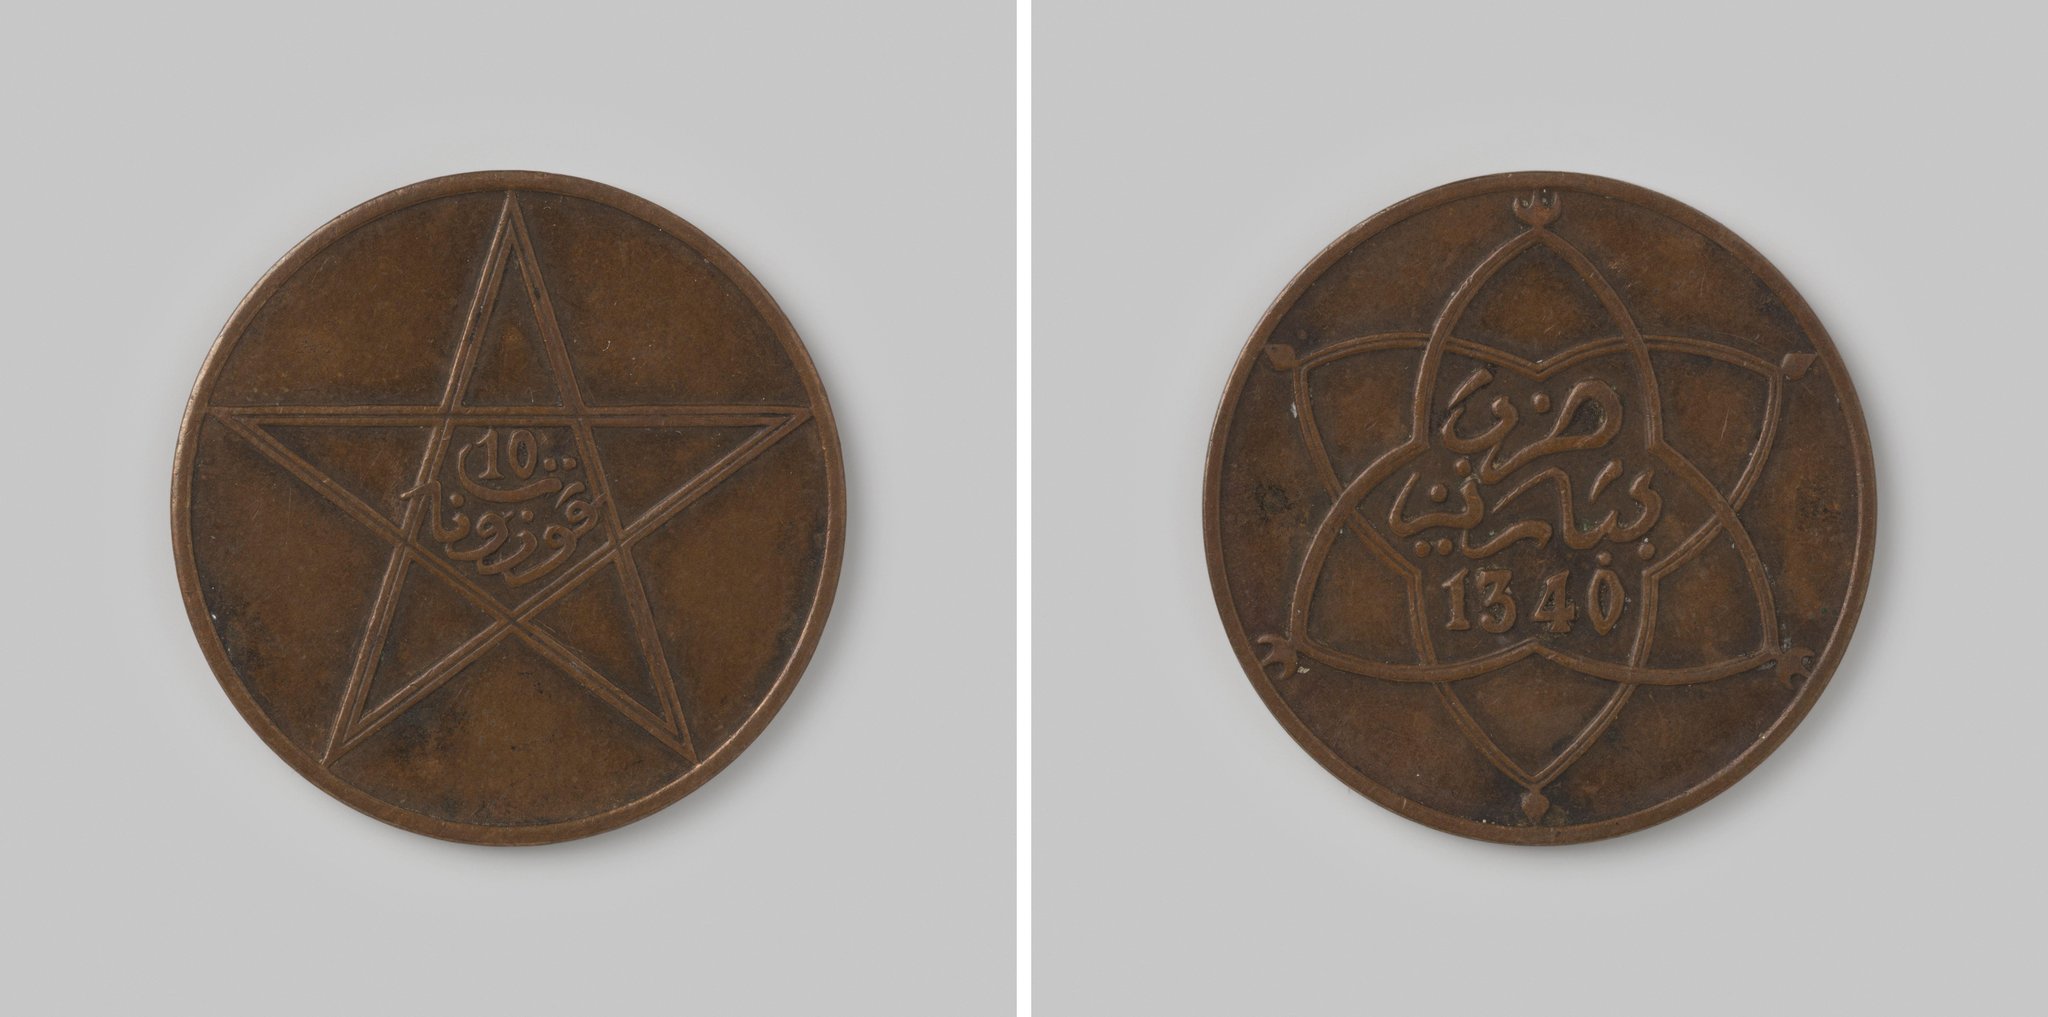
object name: coin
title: 10 mazunas uit het Franse protectoraat Marokko, 1340 [=1921]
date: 1921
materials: bronze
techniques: striking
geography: paris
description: Bronzen munt. Voorzijde: vijfpuntige ster, waarin waarde-aanduiding in Arabisch letters, 10 mazunas. Keerzijde: binnen een uit twee gelijkbenige, waarbij elk been uit een tweepas bestaat, driehoeken samengestelde zespuntige ster tweeregelig opschrift in Arabische letters met aanduiding muntplaats: bi Bariz [=Parijs]. Daaronder jaartal in Westers-Arabische cijfers:1340 [=1921]. Gladde rand.